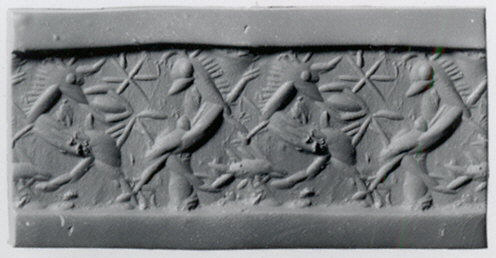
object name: cylinder seal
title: Cylinder seal with monster contest scene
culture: babylonian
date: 900-701 BCE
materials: gemstone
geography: mesopotamia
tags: animals